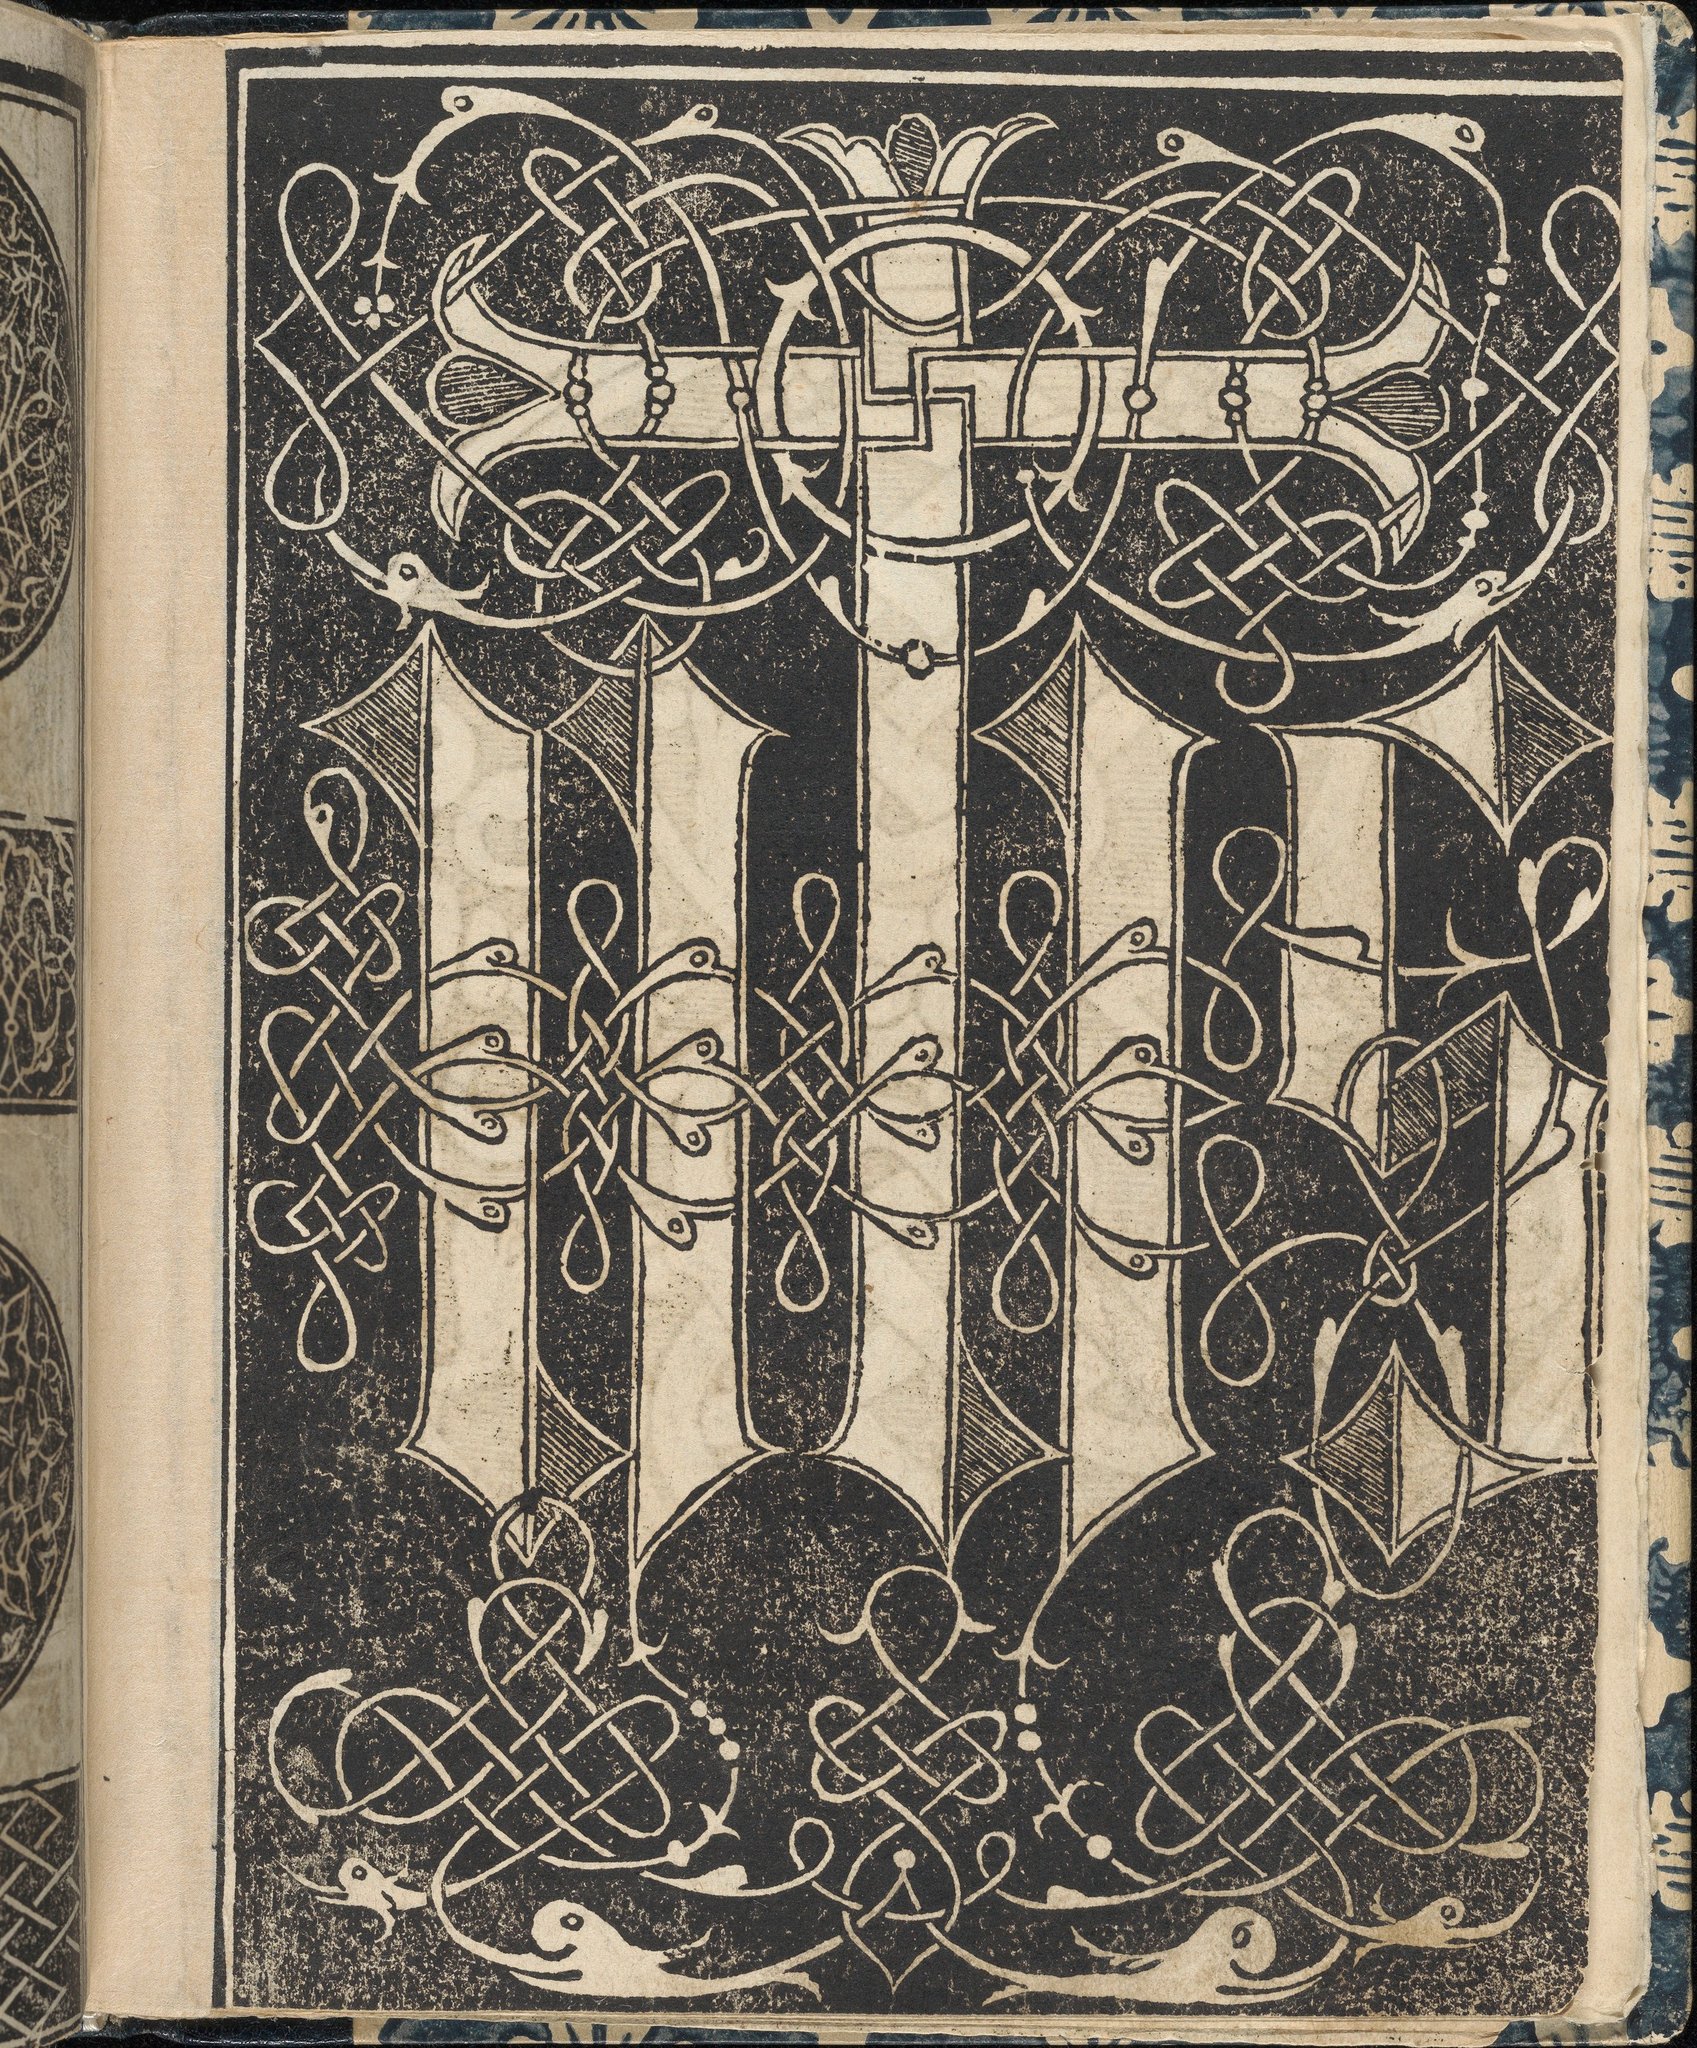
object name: book print ornament architecture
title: Essempio di recammi, page 17 (recto)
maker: giovanni antonio tagliente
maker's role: author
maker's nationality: italian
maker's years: 1465-1528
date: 1530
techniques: woodcut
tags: ornament